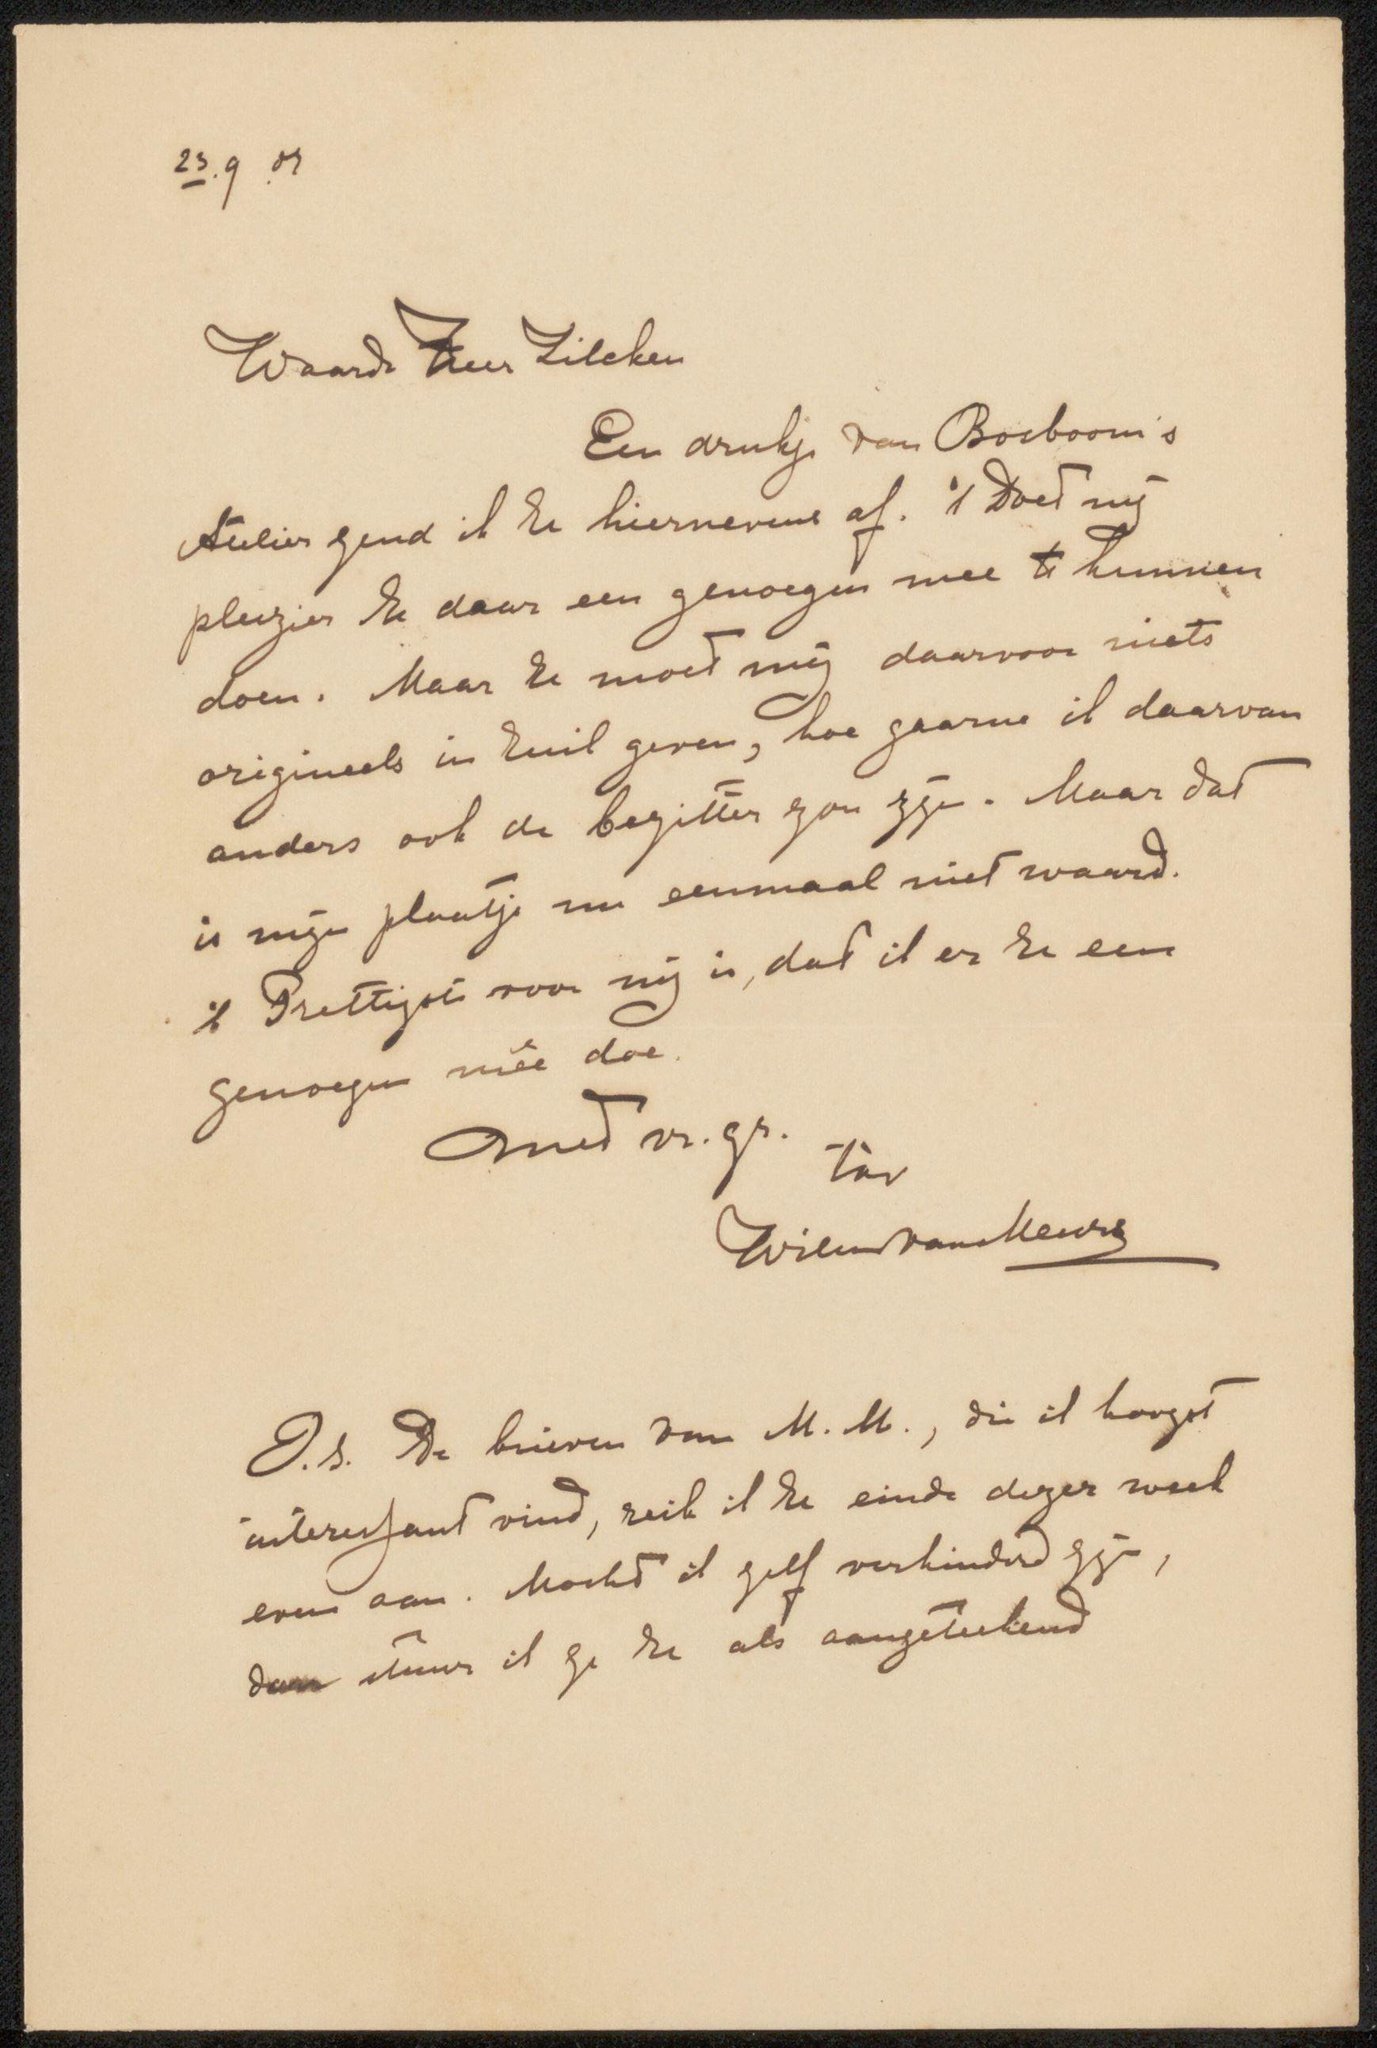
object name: letter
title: Brief aan Philip Zilcken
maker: willem jan gerrit van meurs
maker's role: artist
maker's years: 1872-1956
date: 1907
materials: ink, paper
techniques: pen, writing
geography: haarlem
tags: johannes bosboom, the hague, london, painter, print maker, draughtsman, matthijs maris, philip zilcken, workshop, studio of the artist (in general)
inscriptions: collector's mark: ‘RPK’